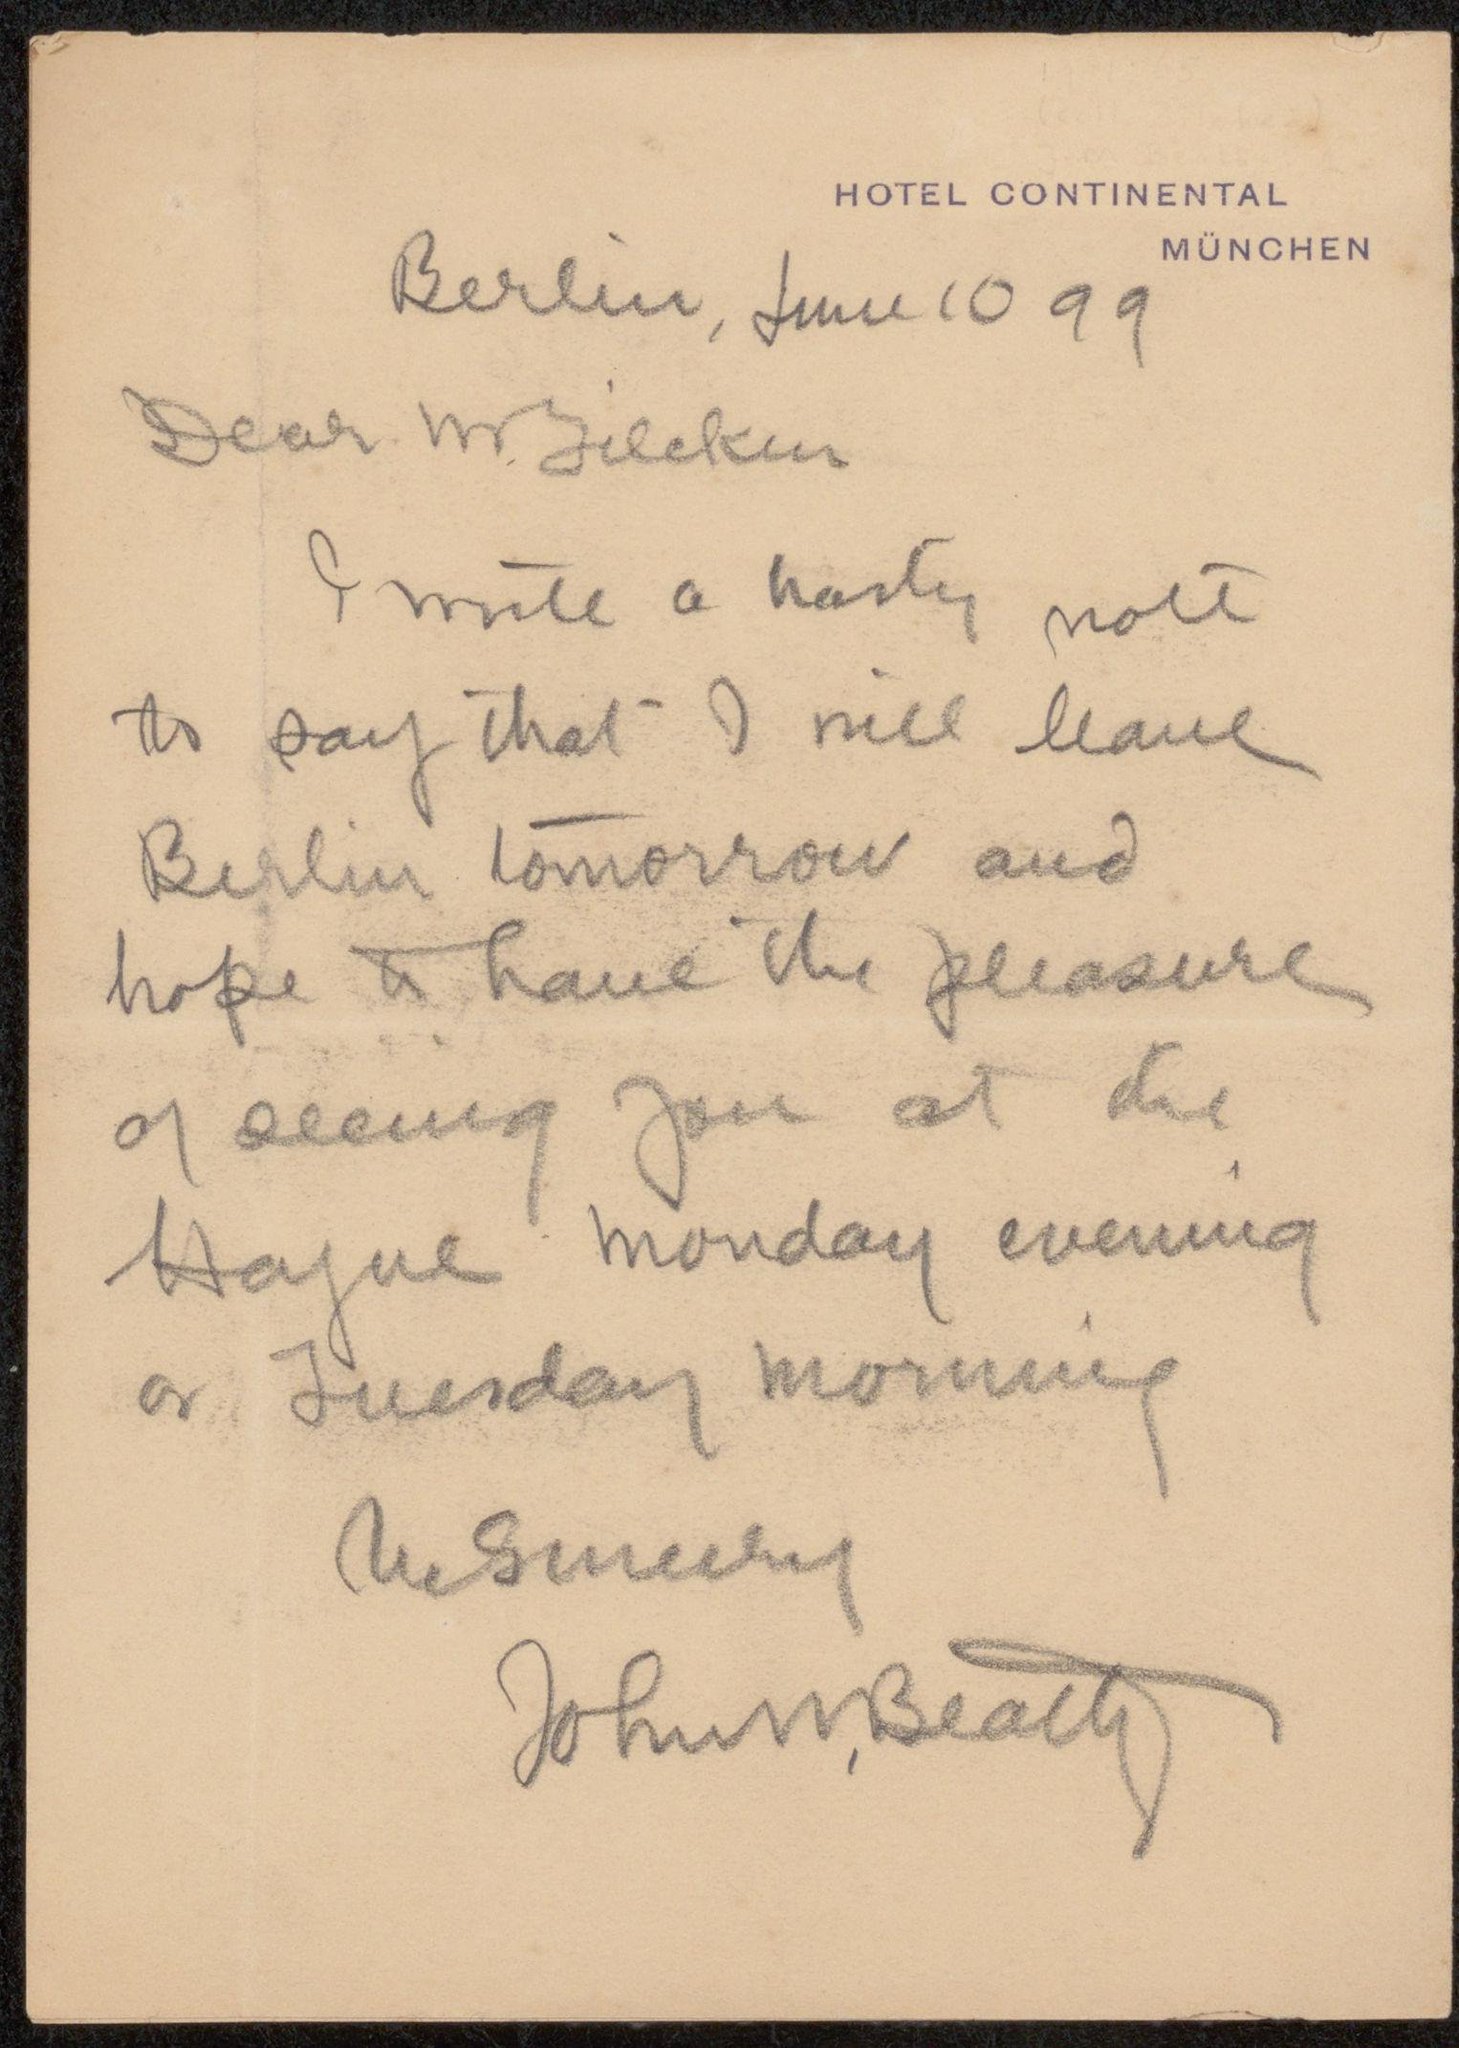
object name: letter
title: Brief aan Philip Zilcken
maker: john wesley beatty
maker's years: 1851-1924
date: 1899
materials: paper, pencil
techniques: printing, writing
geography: berlin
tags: the hague, painter, draughtsman, philip zilcken, berlin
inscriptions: collector's mark: ‘RPK’